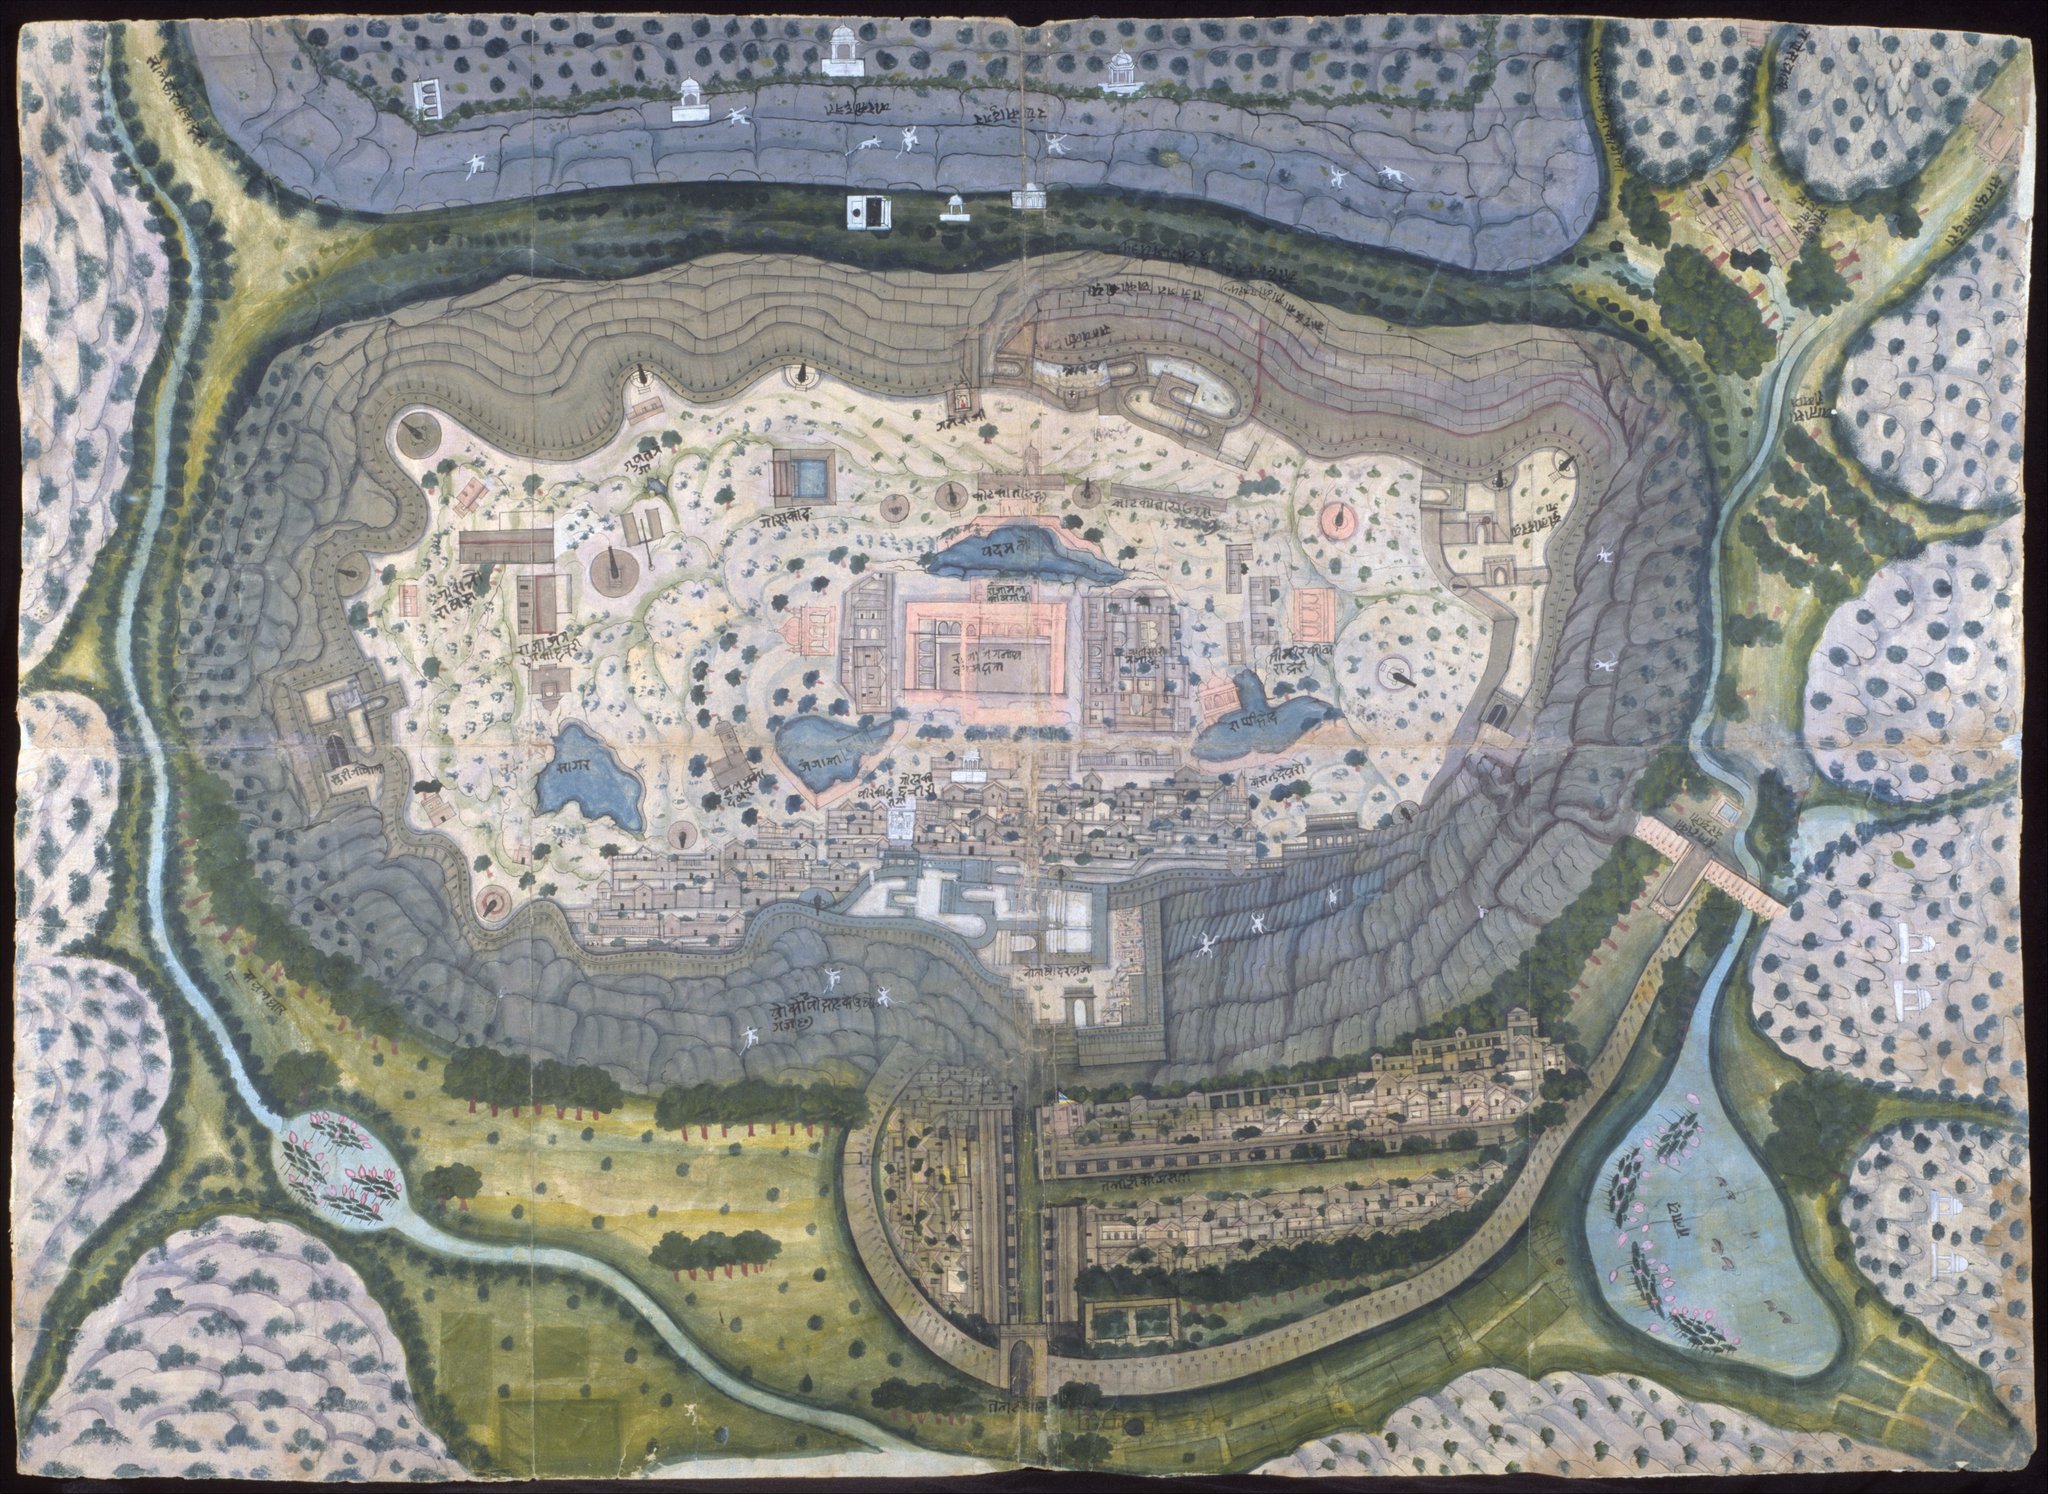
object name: painting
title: Fortified City of Ranthambhor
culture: indian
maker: bagta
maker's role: artist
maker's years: 1751-1824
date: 1810-1818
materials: ink, paper, watercolor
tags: cities,maps